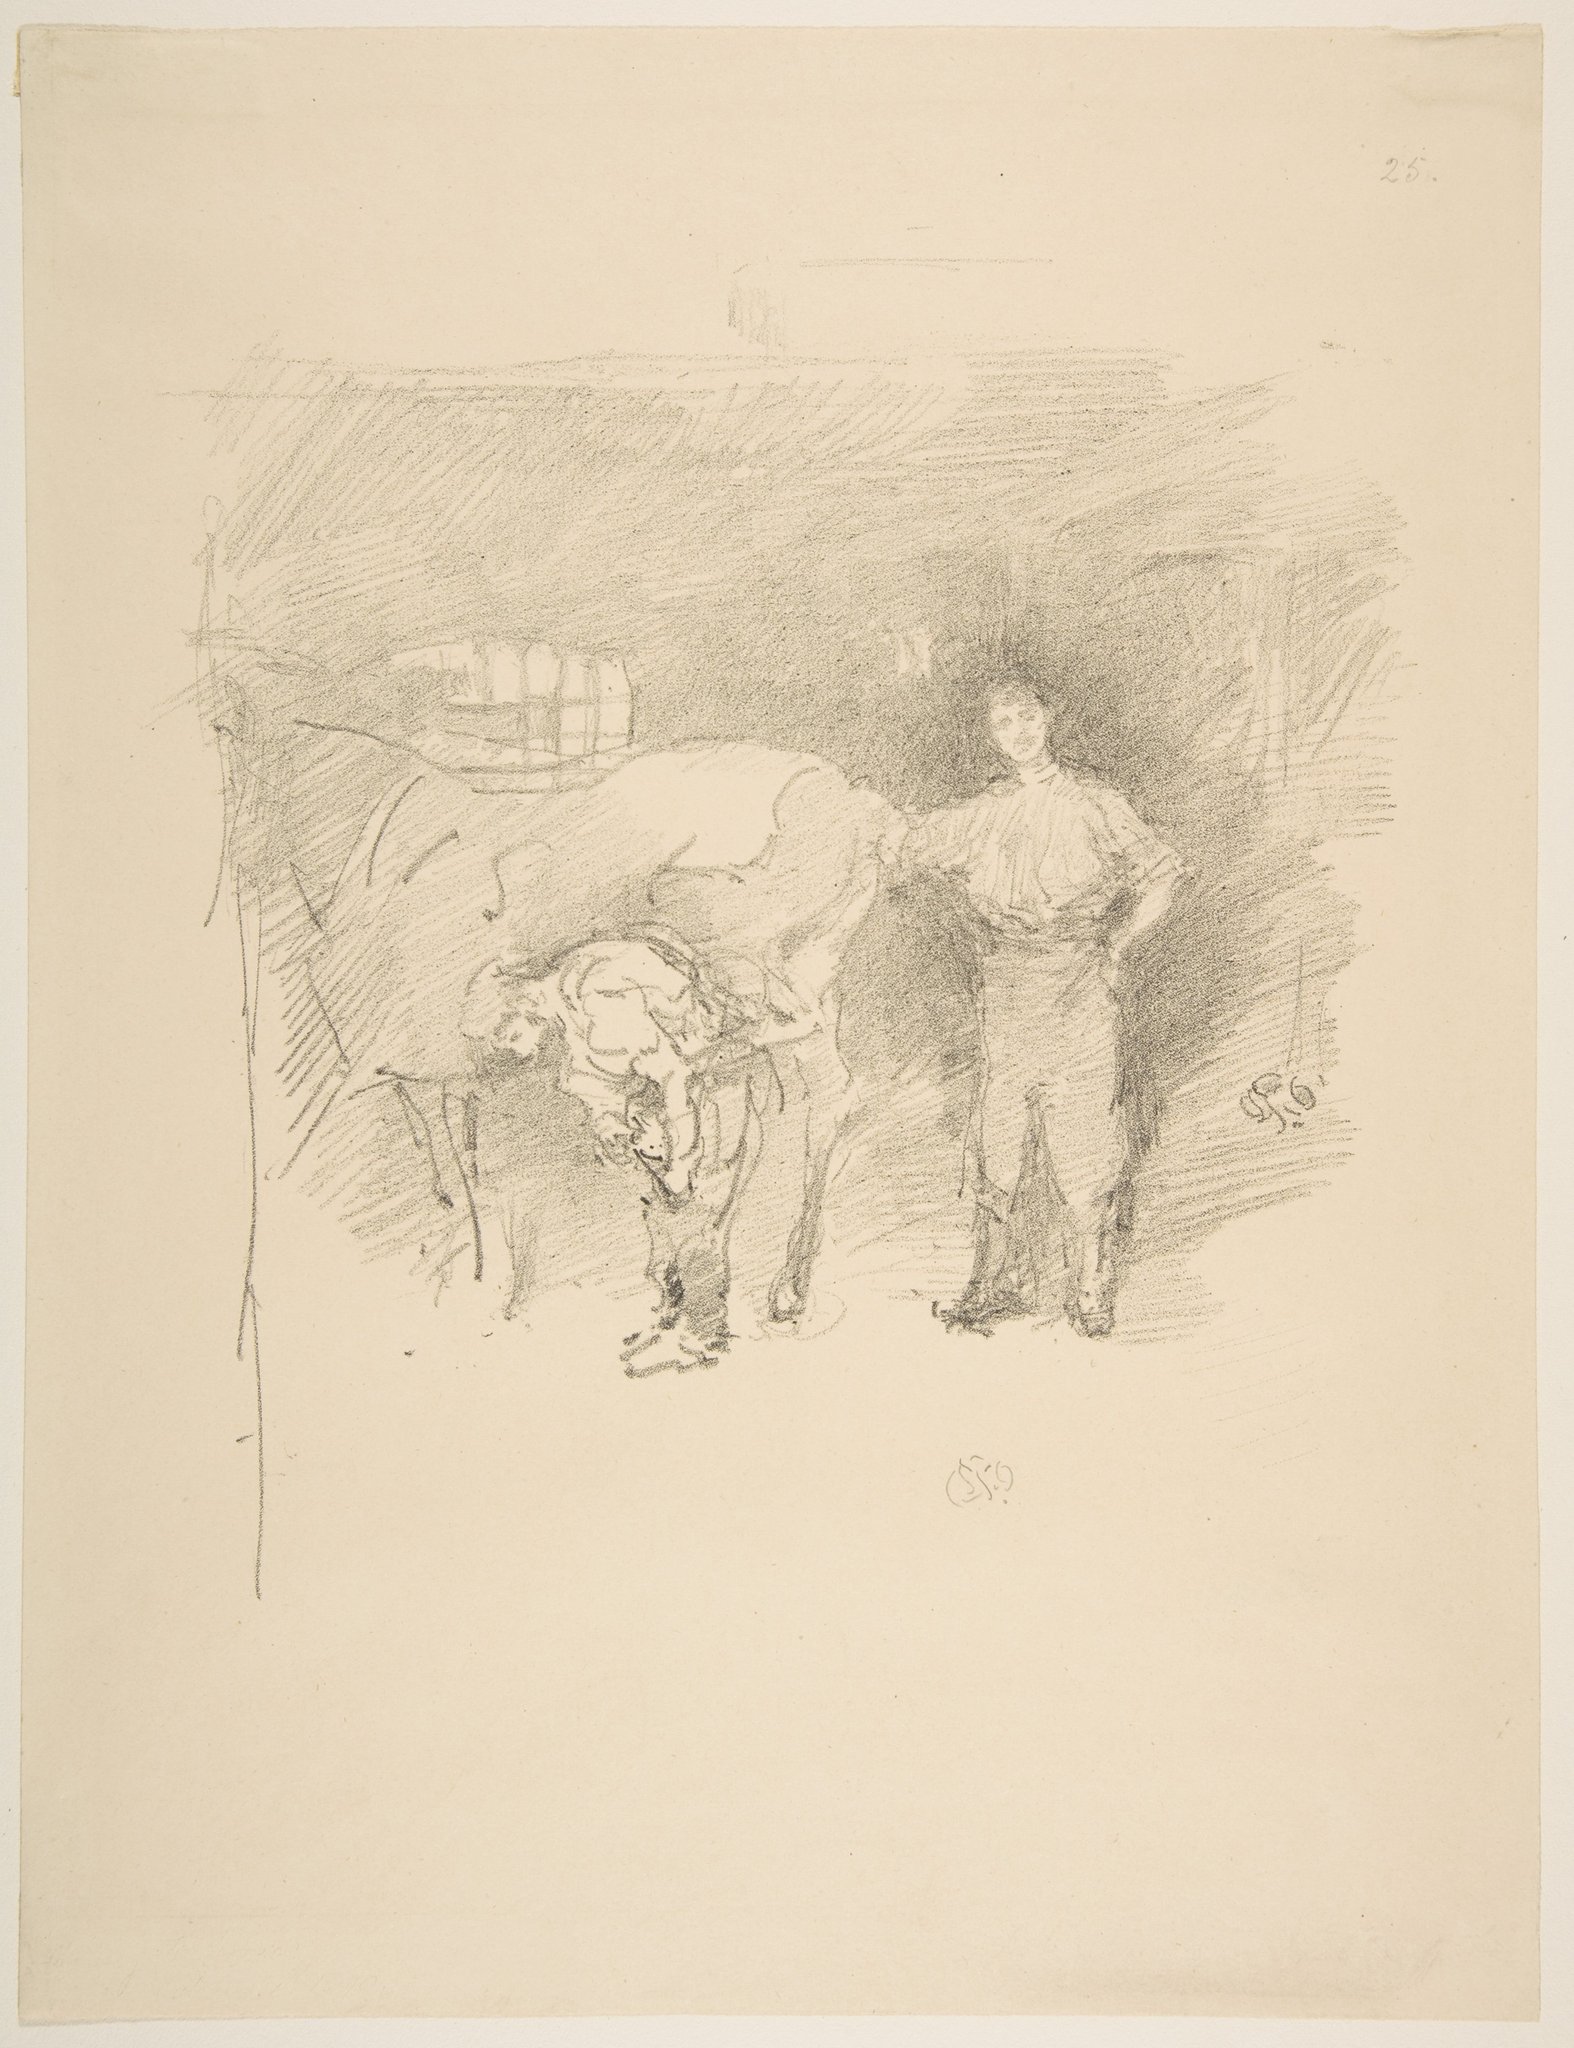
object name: print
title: The Farriers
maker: james mcneill whistler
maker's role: artist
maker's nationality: american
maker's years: 1834-1903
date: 1888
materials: ink, paper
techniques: printing, lithography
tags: men,horses